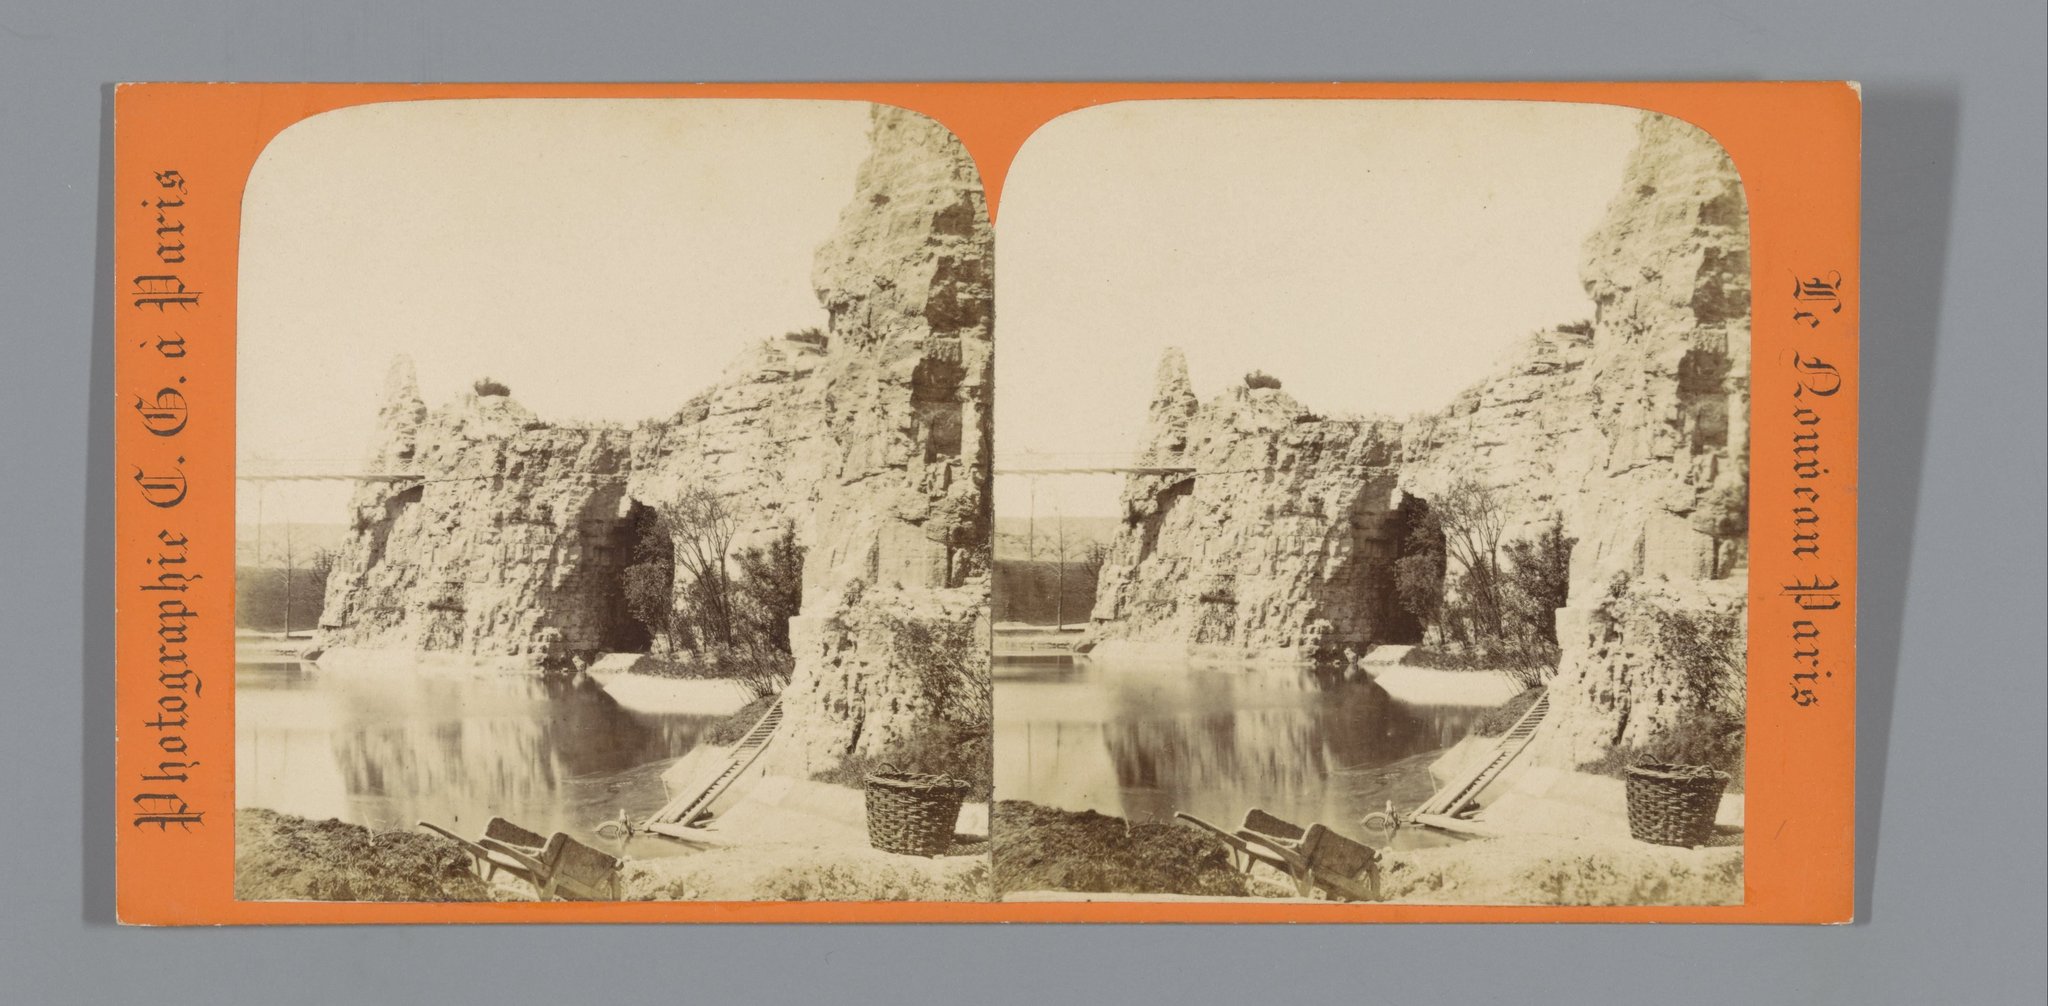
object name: stereograph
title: Gezicht op een rotsformatie in het Parc des Buttes-Chaumont te Parijs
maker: charles gérard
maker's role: fotograaf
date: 1860-1870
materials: cardboard, photographic support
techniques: albumen print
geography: parc des buttes-chaumont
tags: park, rock-formations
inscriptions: inscription: ‘Photographie C. G. à Paris.’, inscription: ‘Buttes Chaumont’